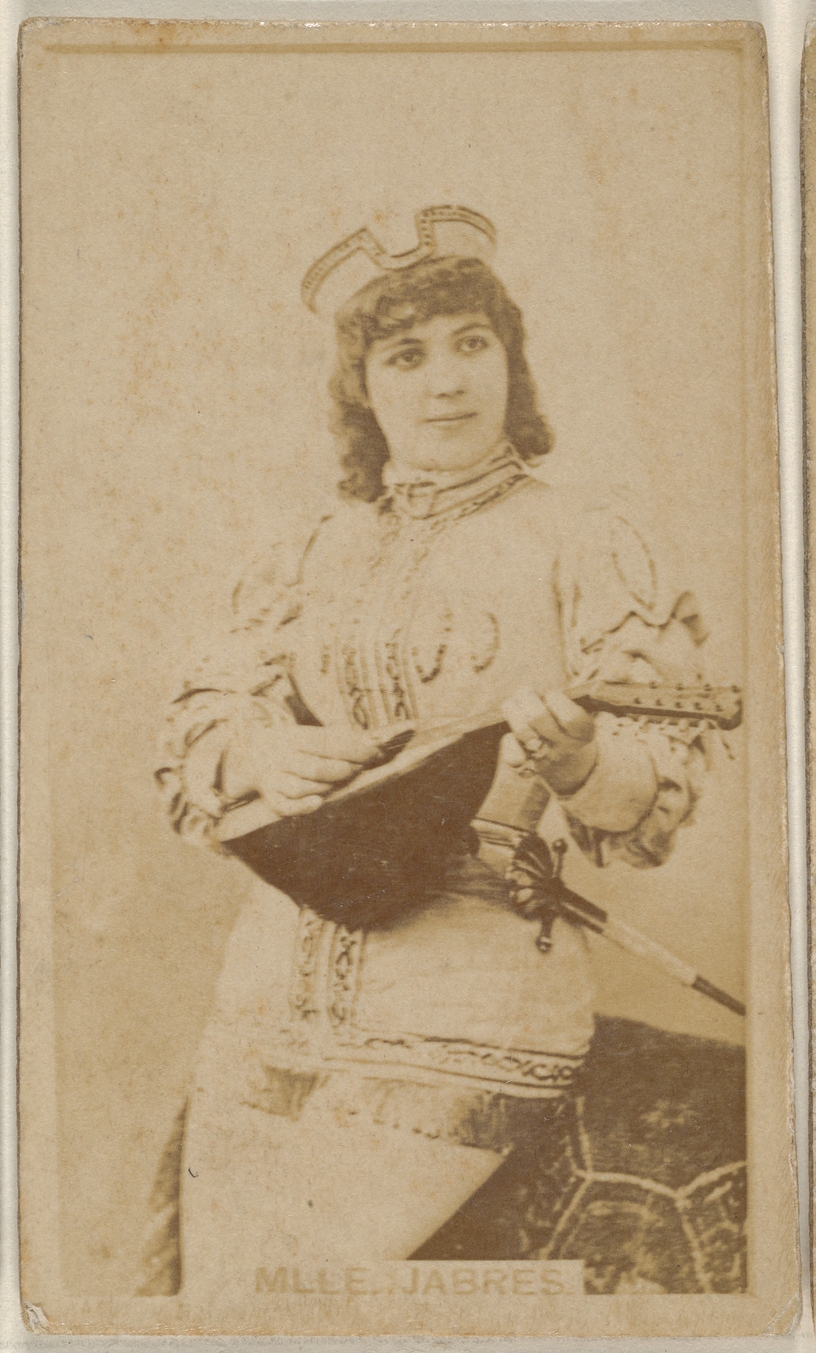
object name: photograph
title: Mlle. Jabres, from the Actors and Actresses series (N45, Type 8) for Virginia Brights Cigarettes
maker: allen & ginter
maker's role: publisher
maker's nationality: american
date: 1888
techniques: albumen silver print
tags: portraits,women,actresses